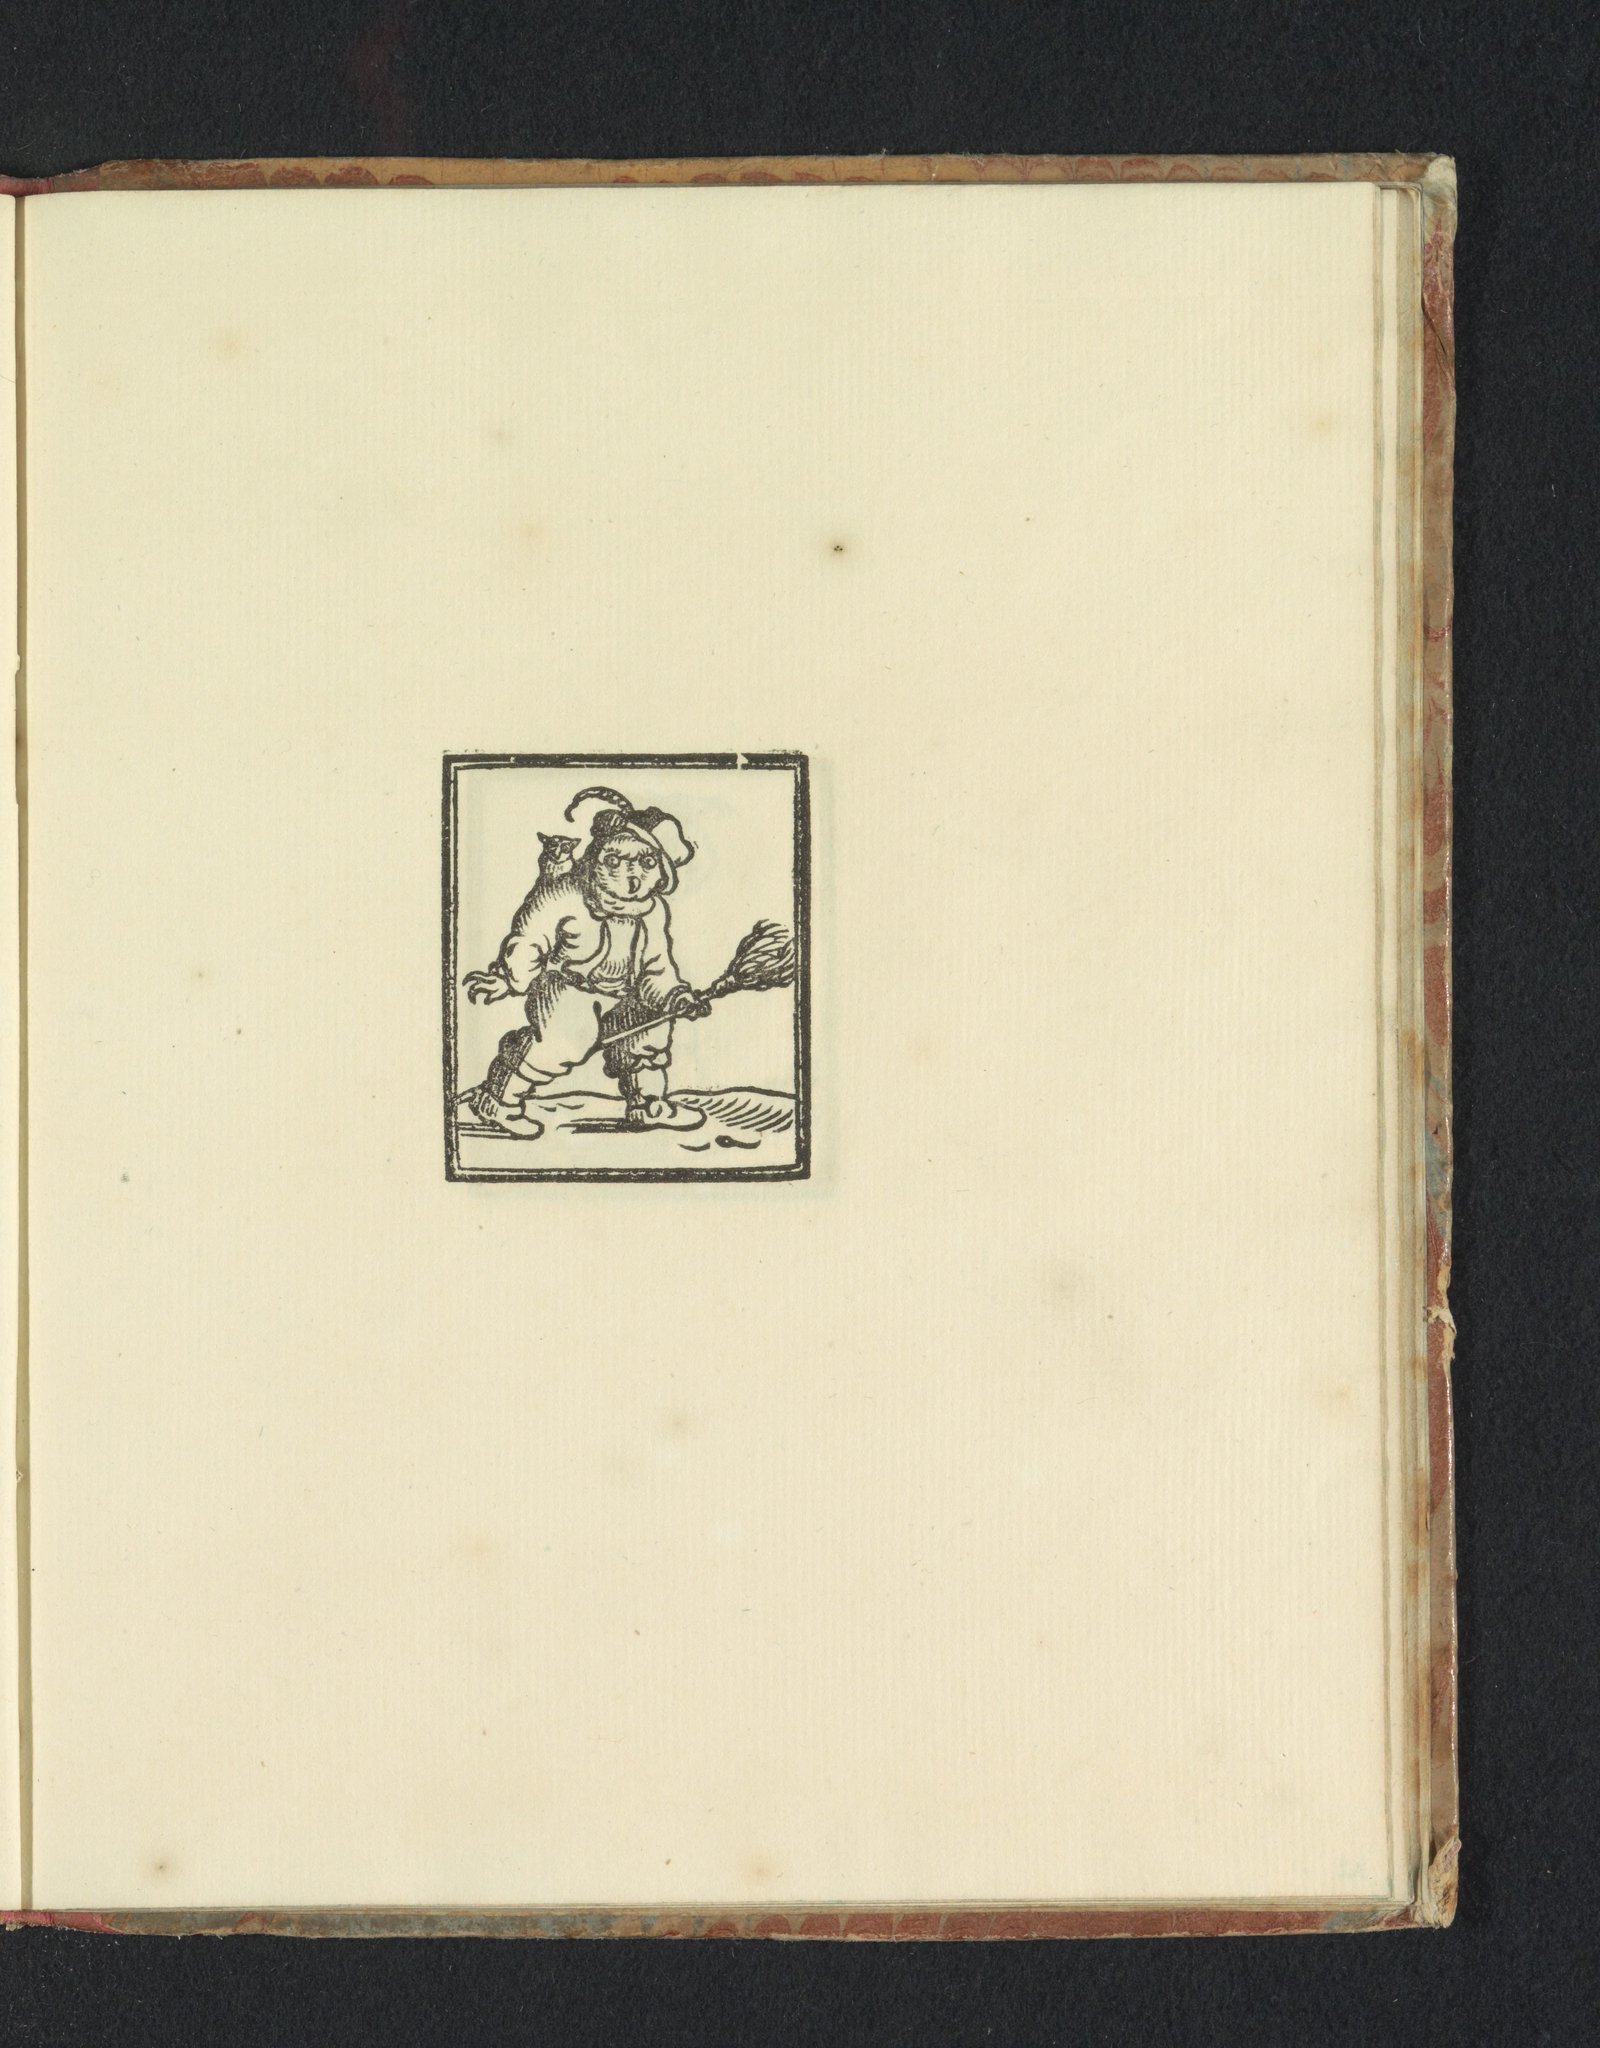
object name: popular print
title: Uylskuyken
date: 1731-1732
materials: paper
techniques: woodcut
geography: haarlem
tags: caricatures (human types)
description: Koddige figuur, in het onderschrift in de overzichtsprent draagt deze figuur de naam: Uylskuyken. Onderdeel van het boekje: XXXVI. aartige figuuren, geinventeert door Izaak van Ostade tot Haarlem [1731-1732].